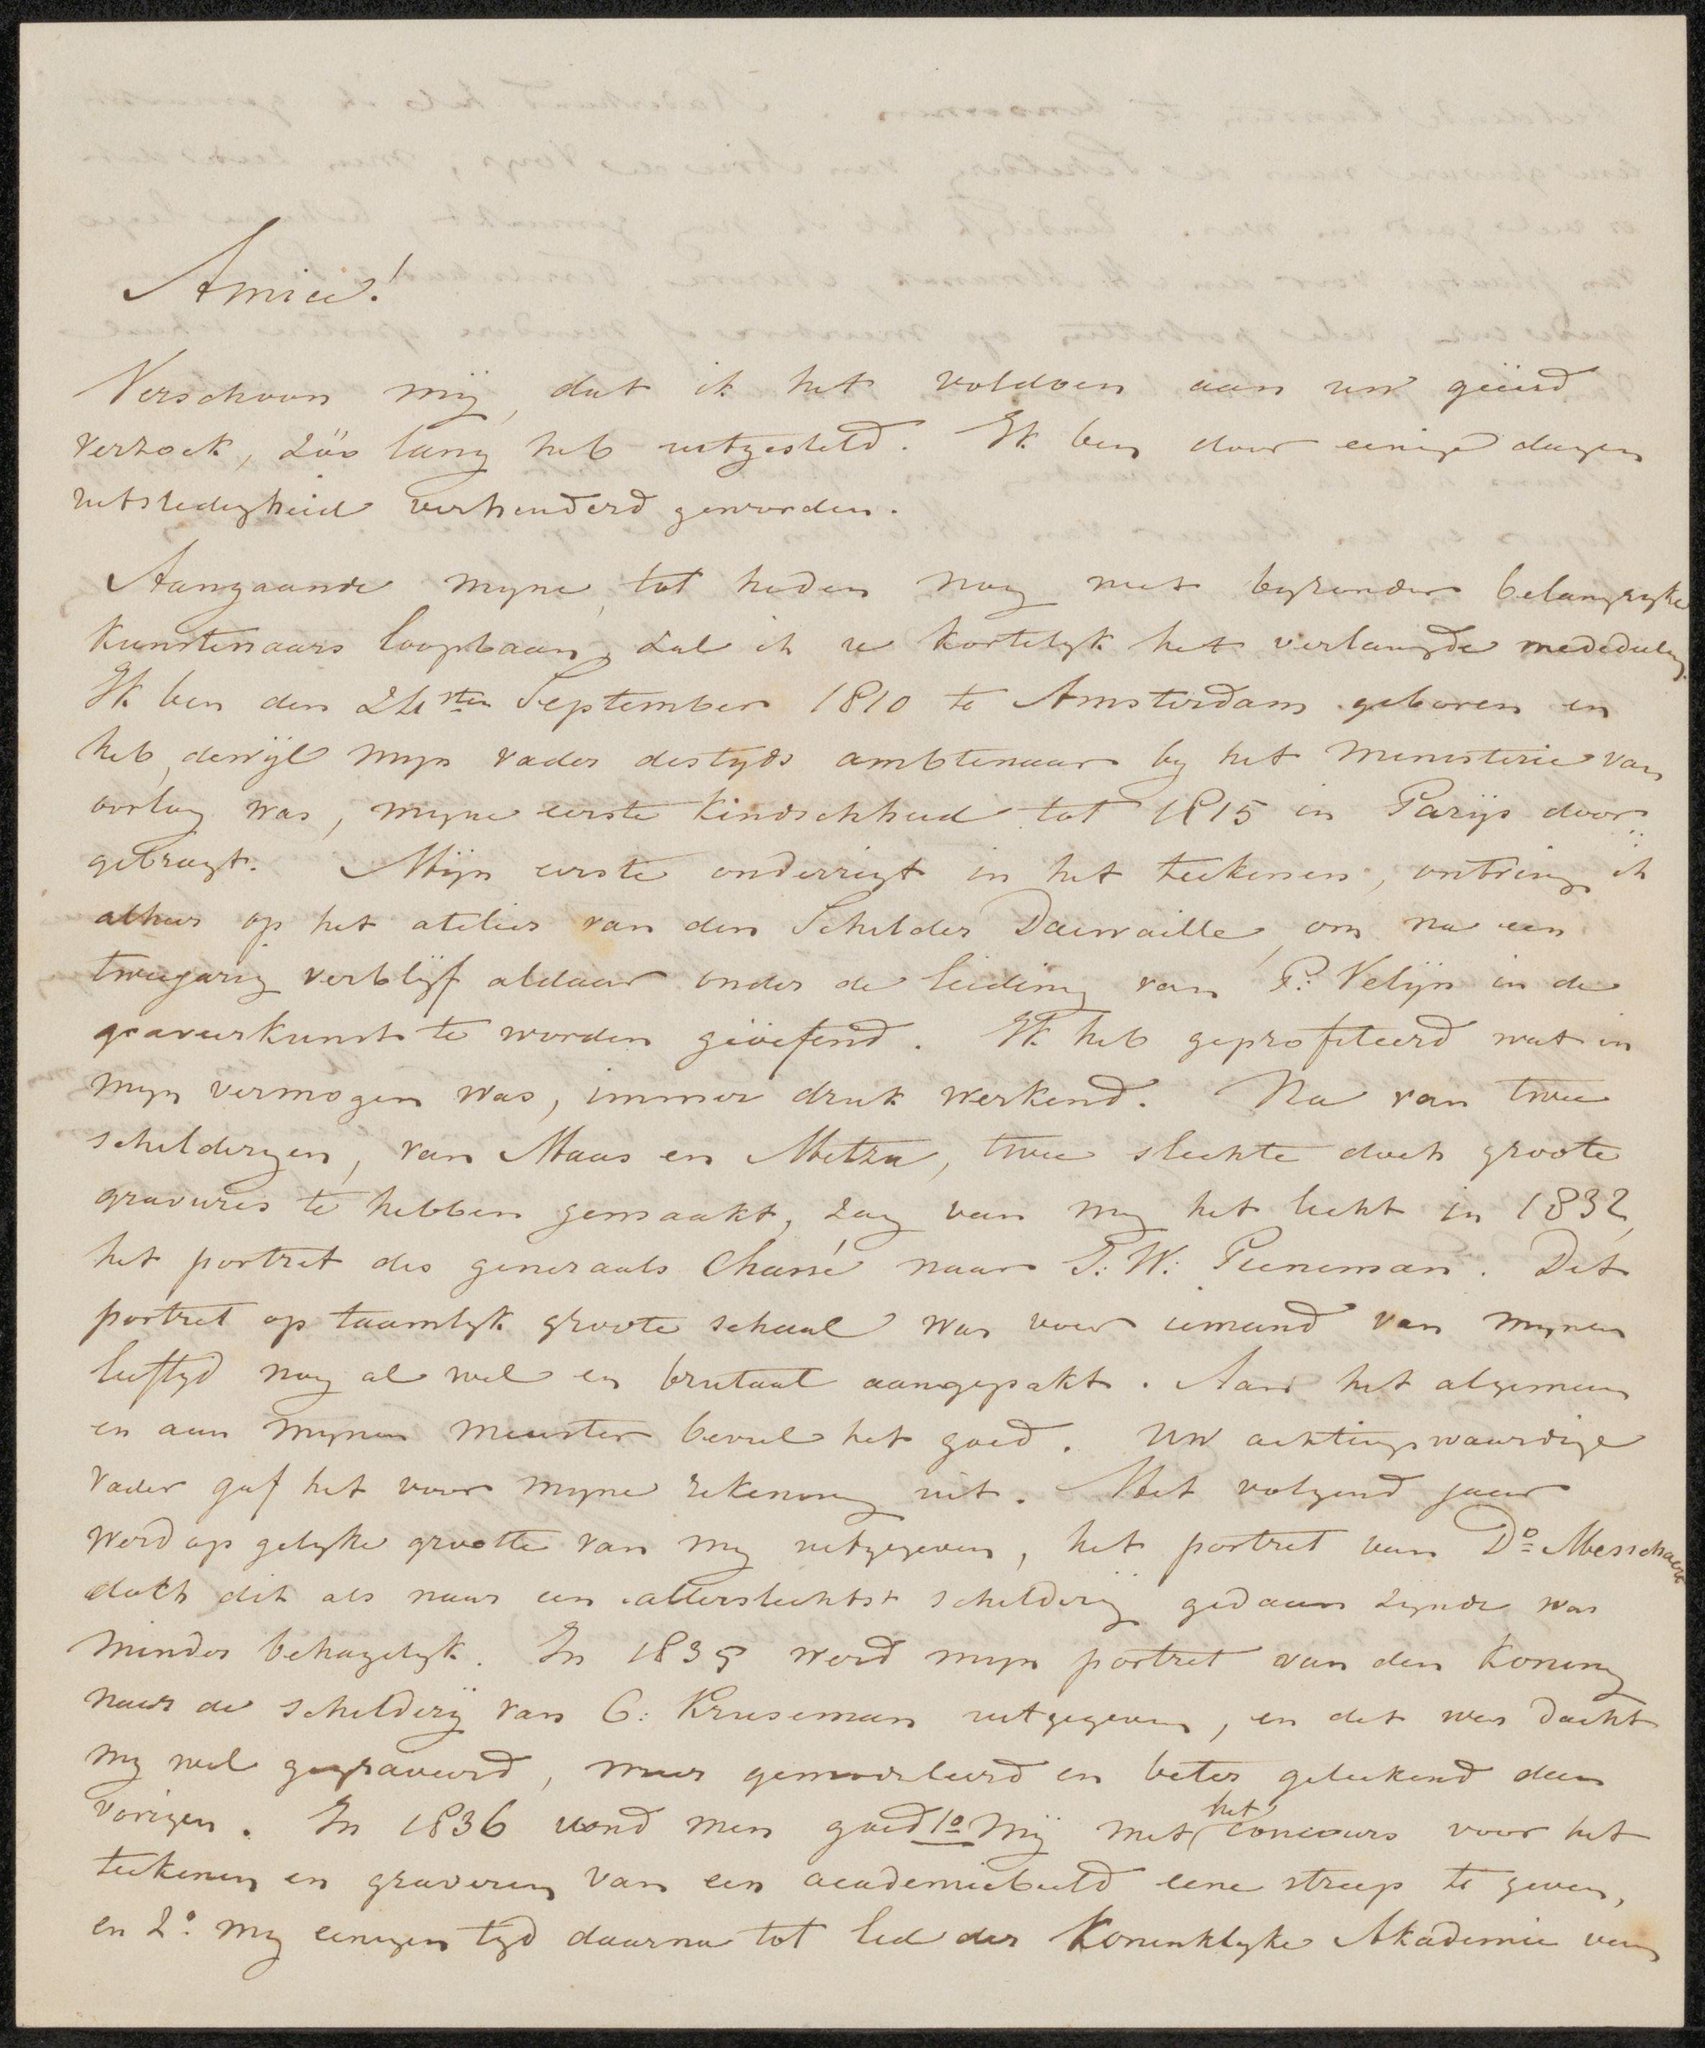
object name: letter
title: Brief aan Christiaan Immerzeel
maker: johannes philippus lange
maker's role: print maker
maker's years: 1810-1849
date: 1842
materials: ink, paper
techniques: pen, writing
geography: amsterdam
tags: the hague, christiaan immerzeel, leiden, philippus velijn, distribution of awards ~ art contest, the graphic arts, anonymous historical person portrayed, education, tuition of the artist (in general), historical persons (portraits and scenes from the life), paris, amsterdam